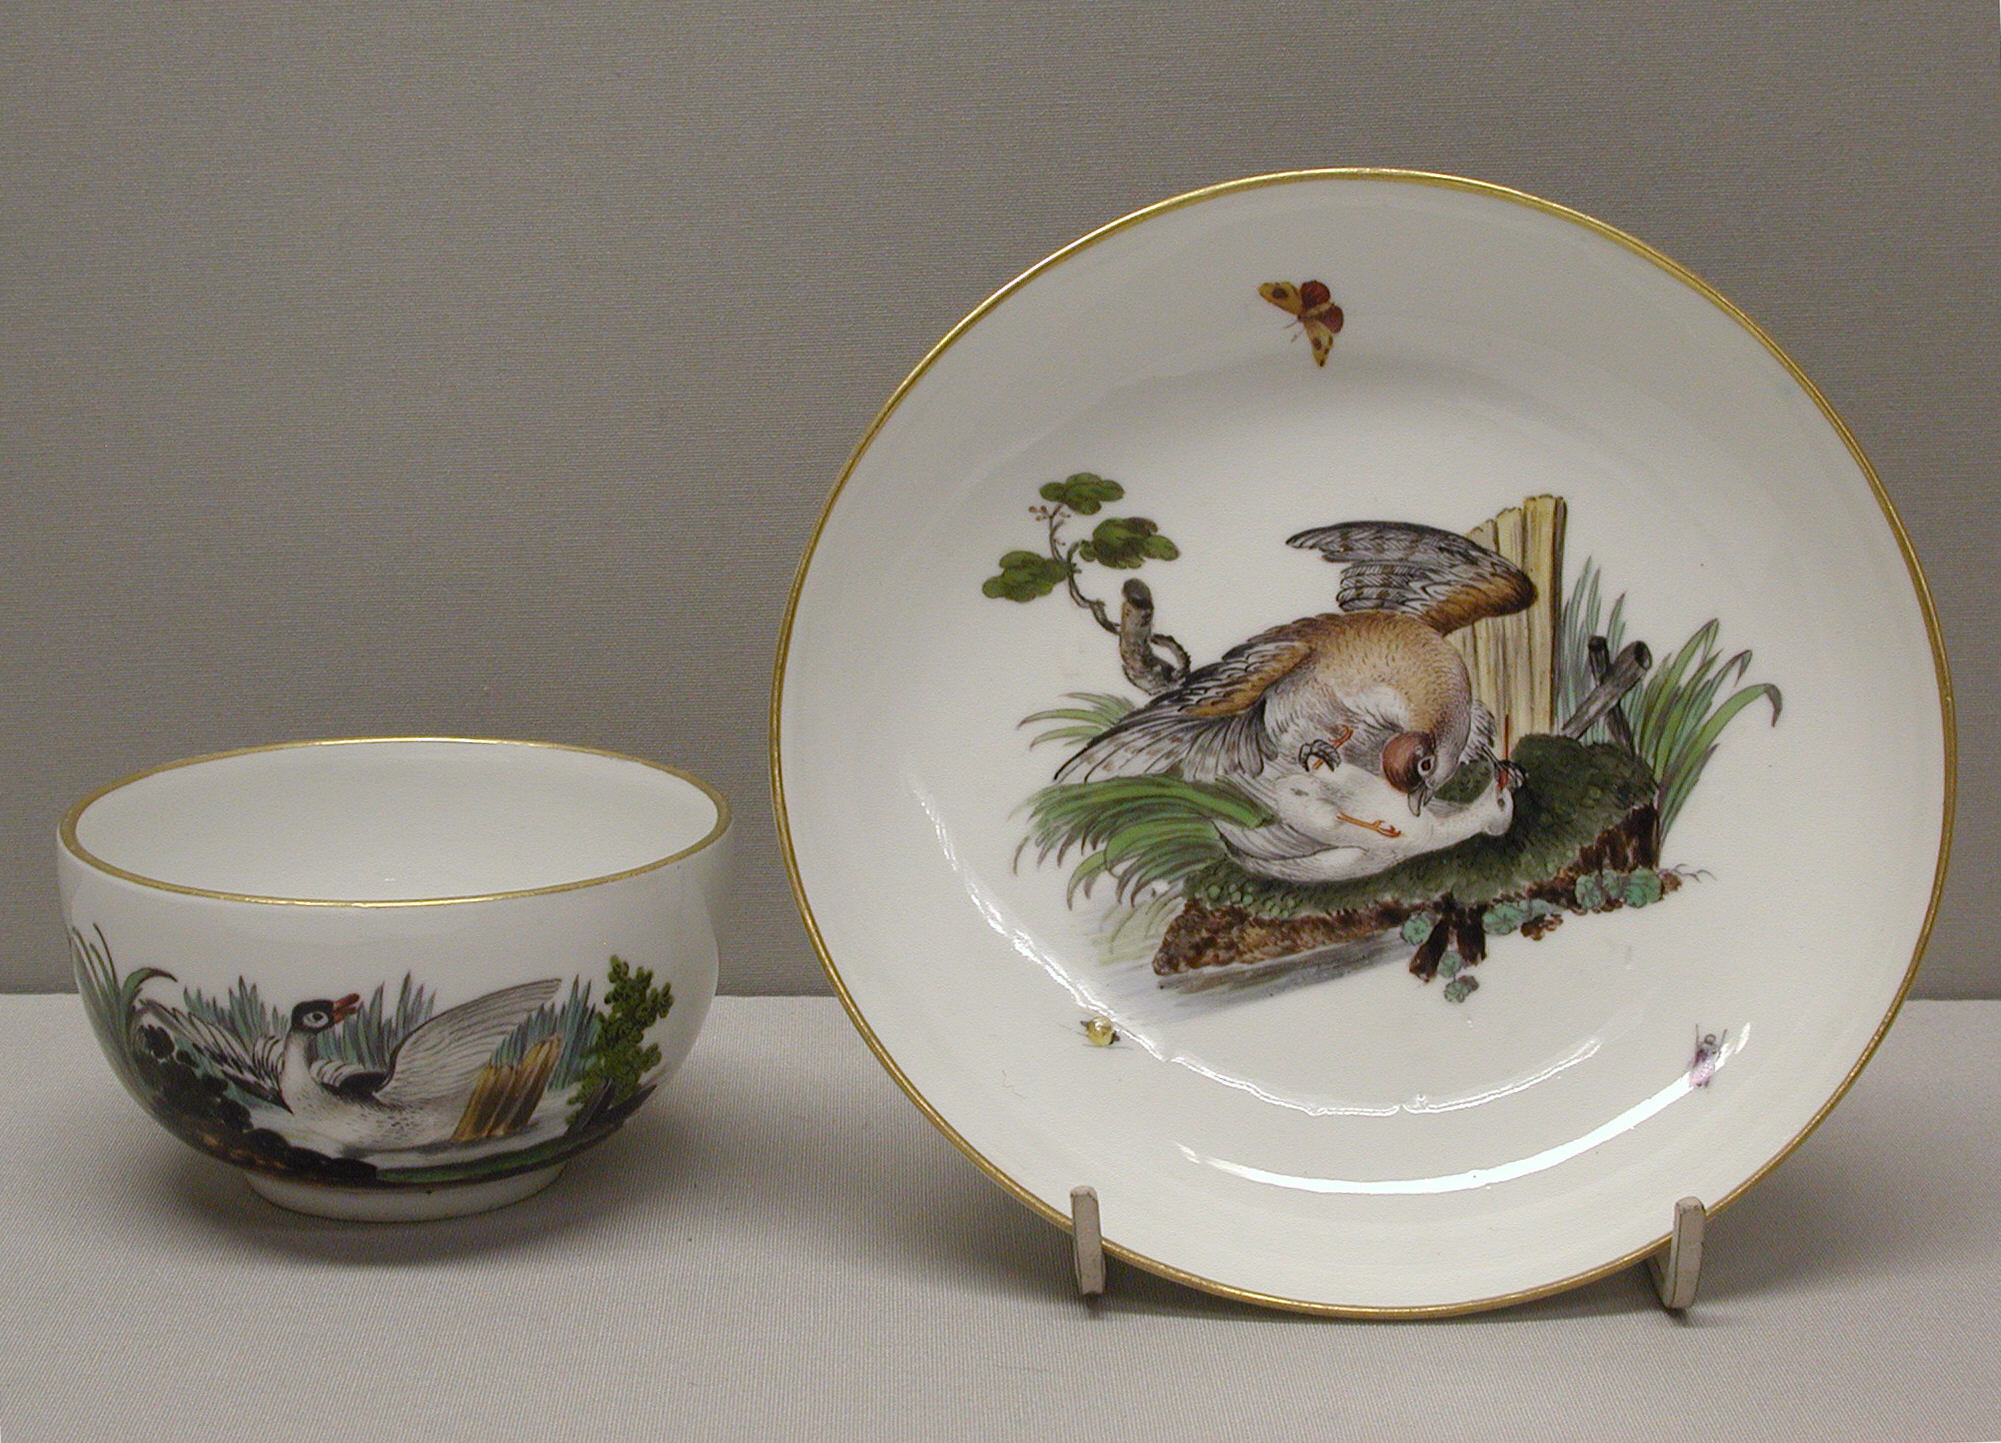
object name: teacup and saucer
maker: höchst manufactory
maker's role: manufactory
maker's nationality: german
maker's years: 1746-1796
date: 1775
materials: hard paste porcelain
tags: birds,butterflies